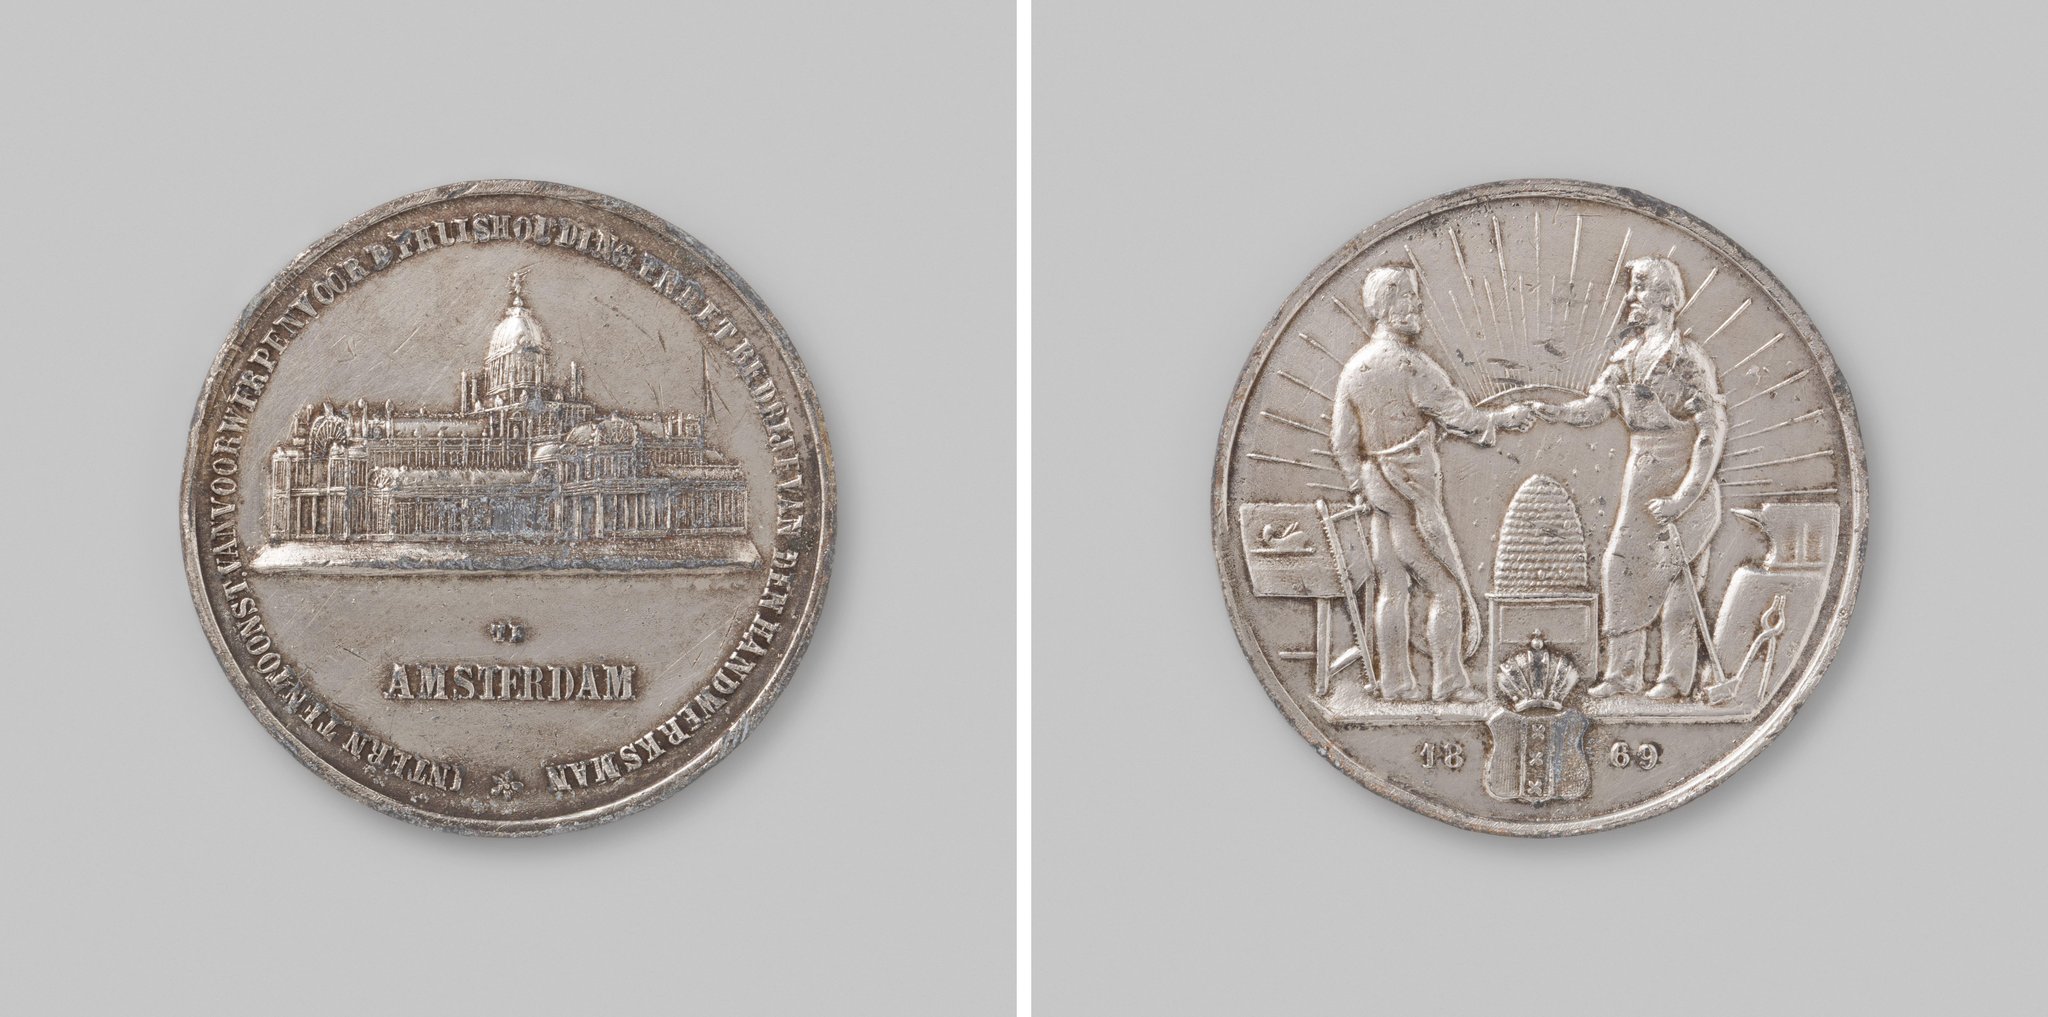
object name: history medal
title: Internationale tentoonstelling van voorwerpen voor de huishouding en het bedrijf van de handwerksman te Amsterdam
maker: Anonymous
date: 1869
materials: tin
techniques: striking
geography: netherlands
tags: amsterdam